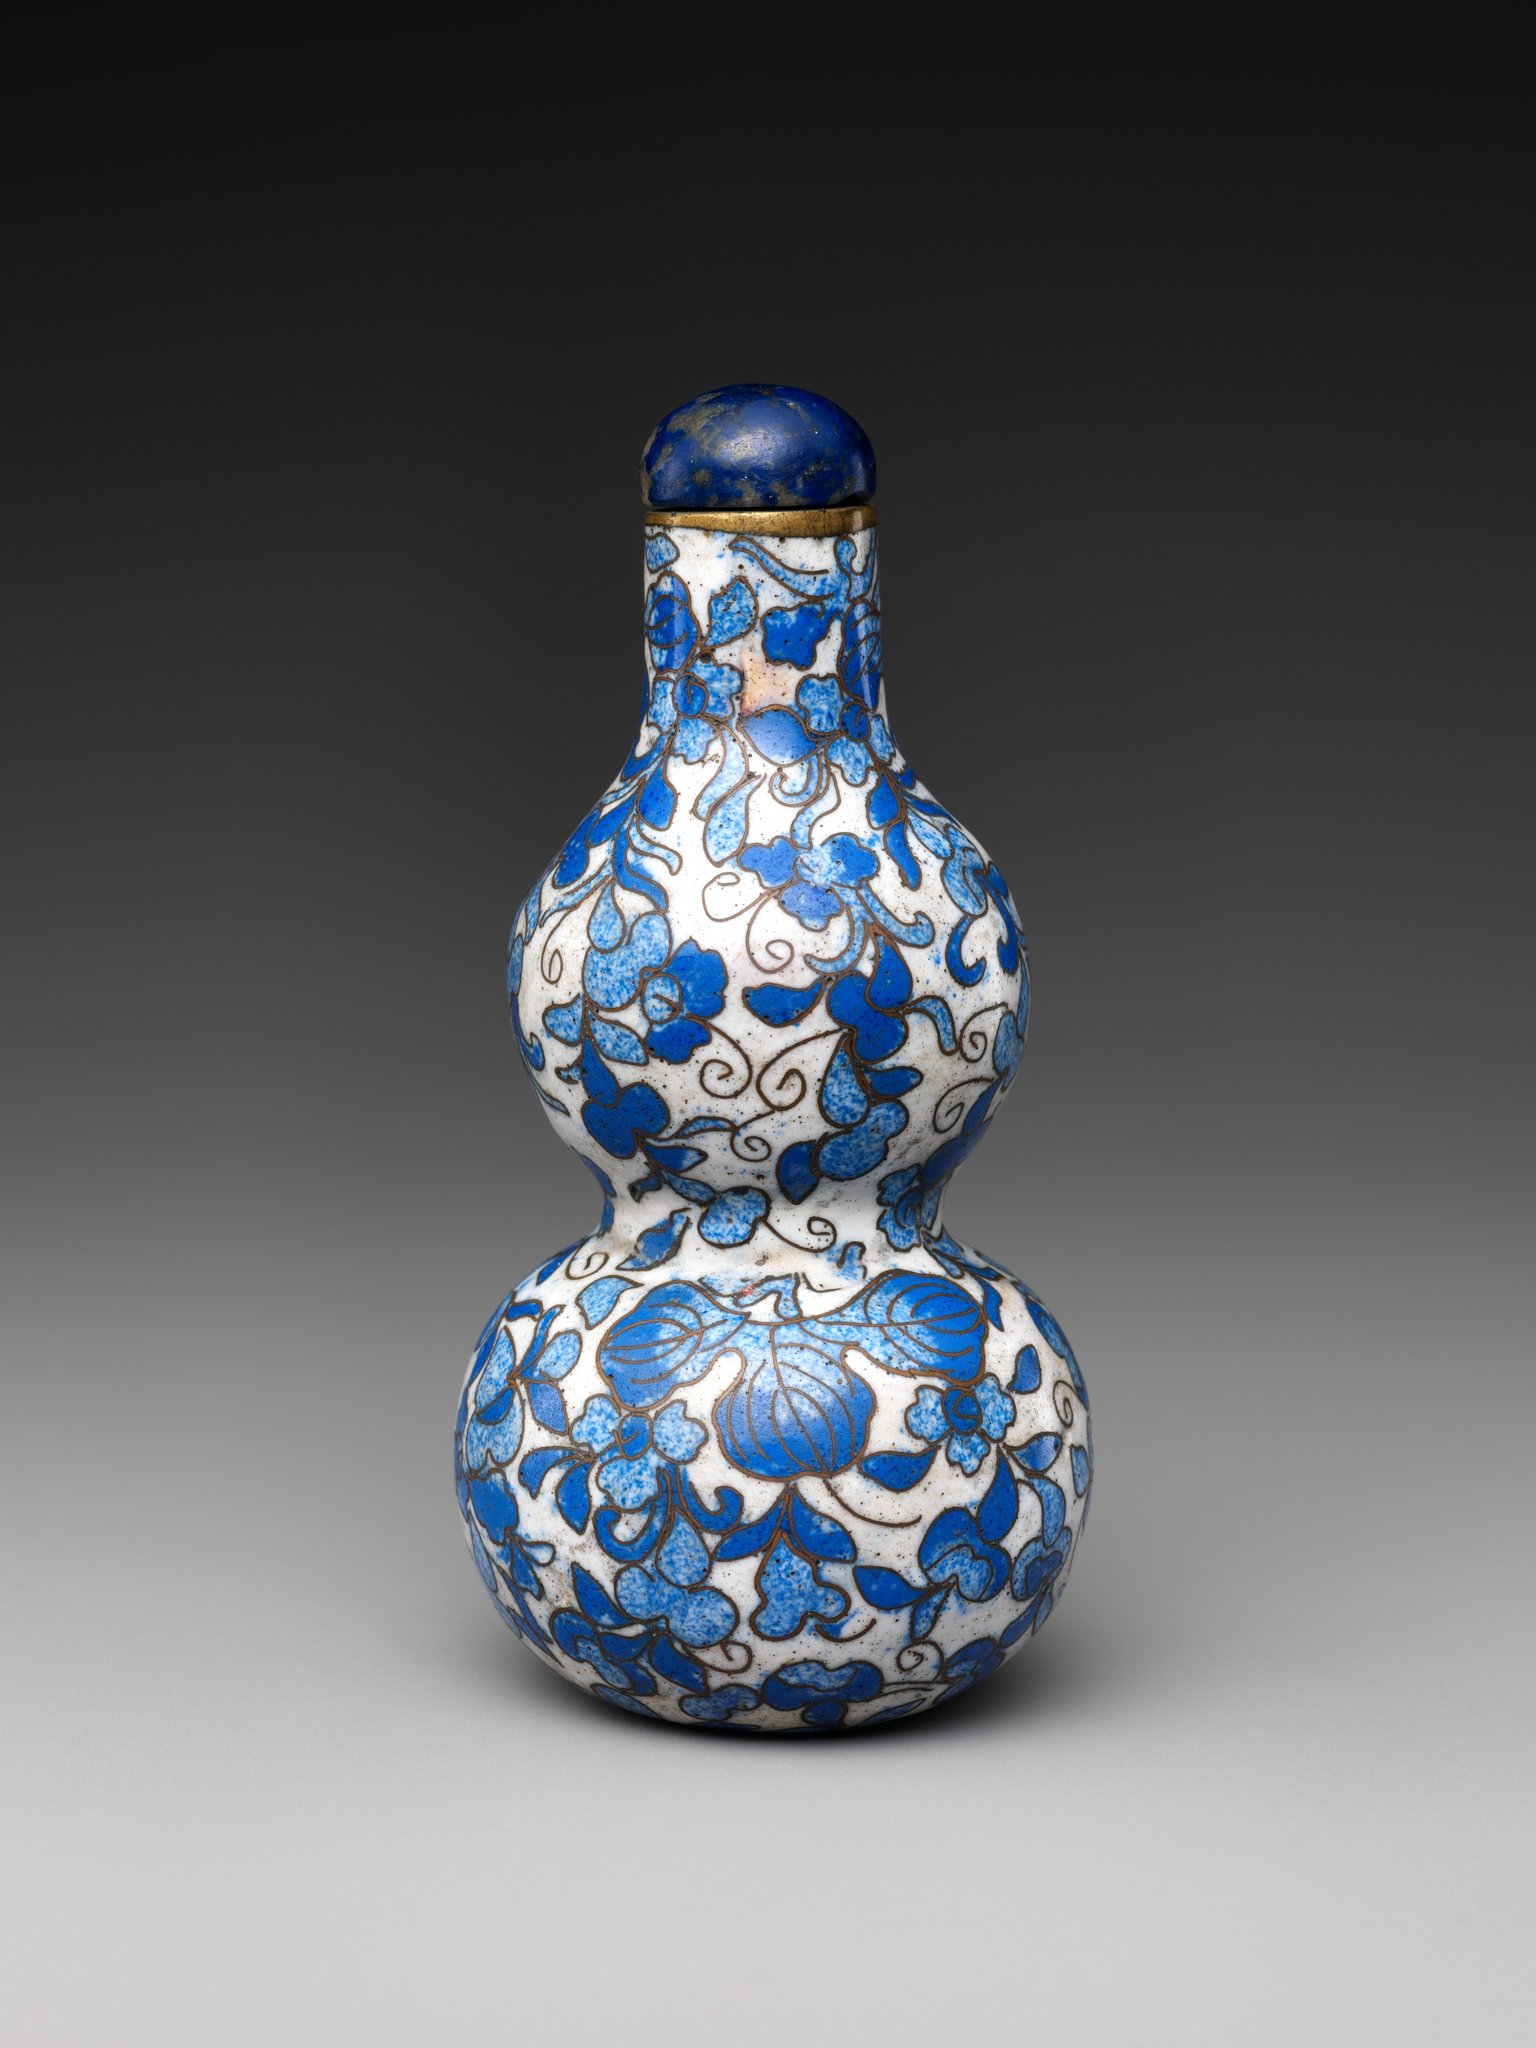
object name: snuff bottle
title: Snuff bottle in the shape of a gourd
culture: chinese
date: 1736-1795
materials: enamel, lapis lazuli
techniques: painting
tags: flowers